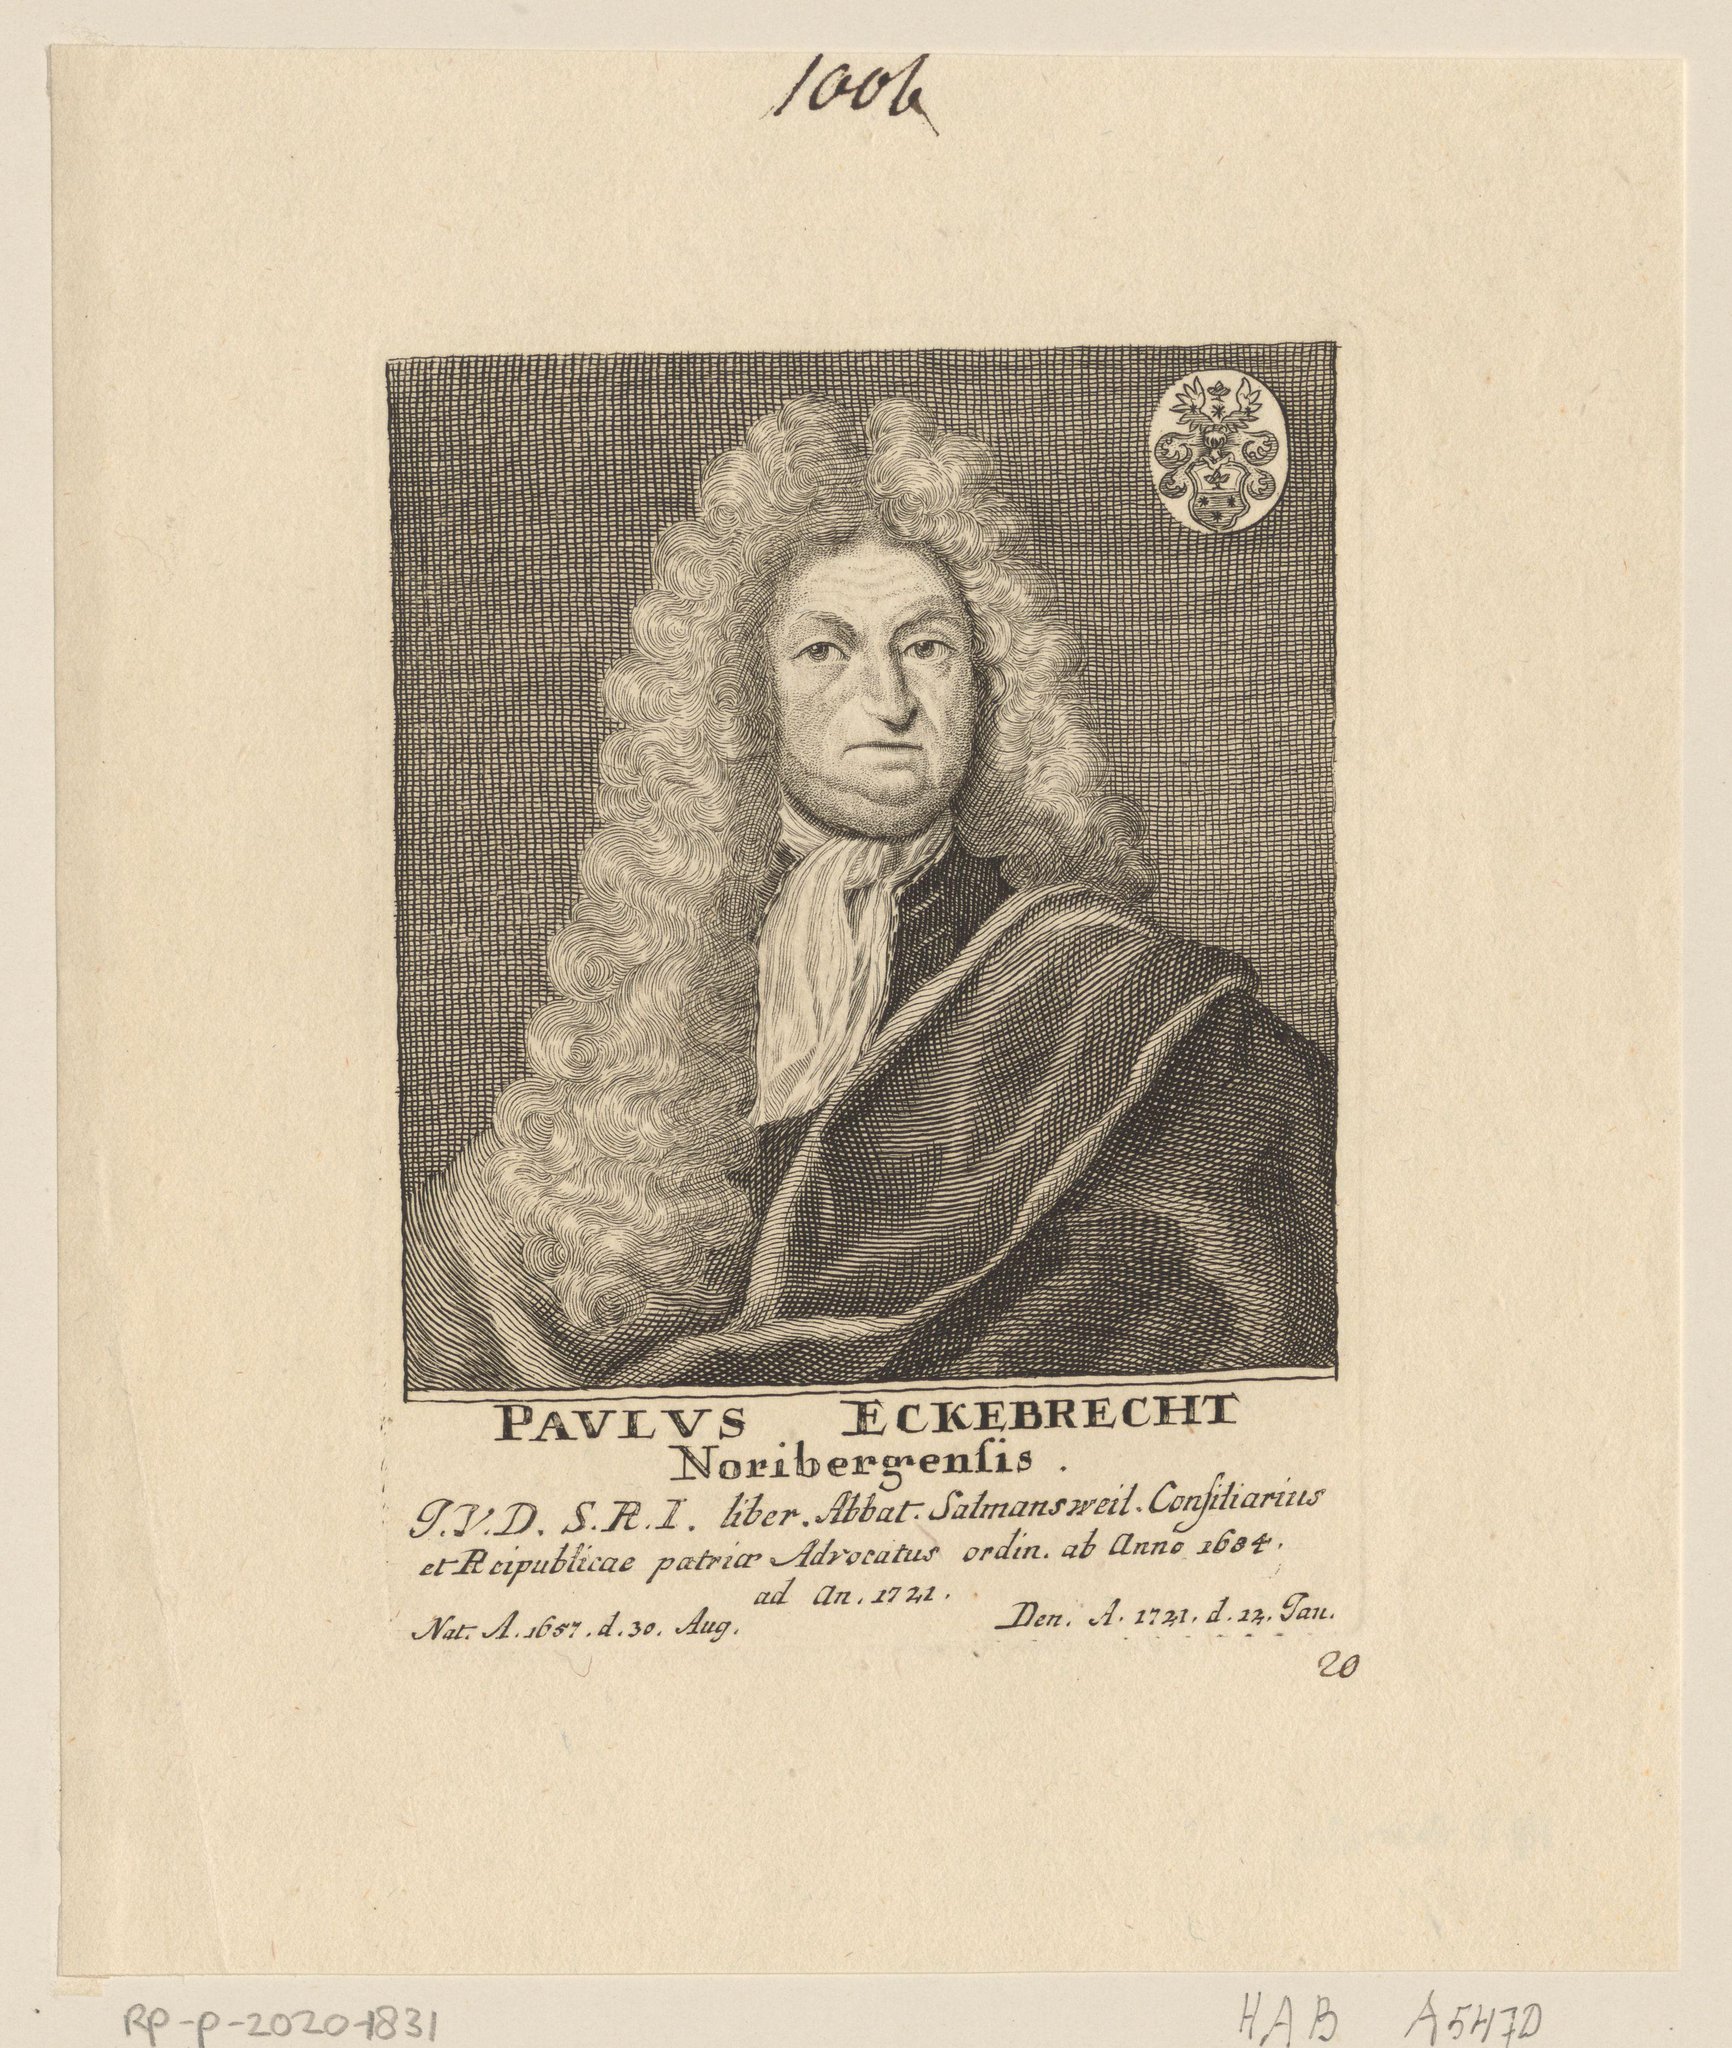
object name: book illustration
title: Portret van Paul Eckebrecht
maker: Anonymous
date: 1725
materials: paper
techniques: engraving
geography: germany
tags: historical persons, armorial bearing, heraldry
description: Prent waarschijnlijk uit: Roth-Scholtz, Friedrich. Icones virorum omnium ordinum eruditione omnique item genere (...). Neurenberg: erven Johann Daniel Tauber, 1725.